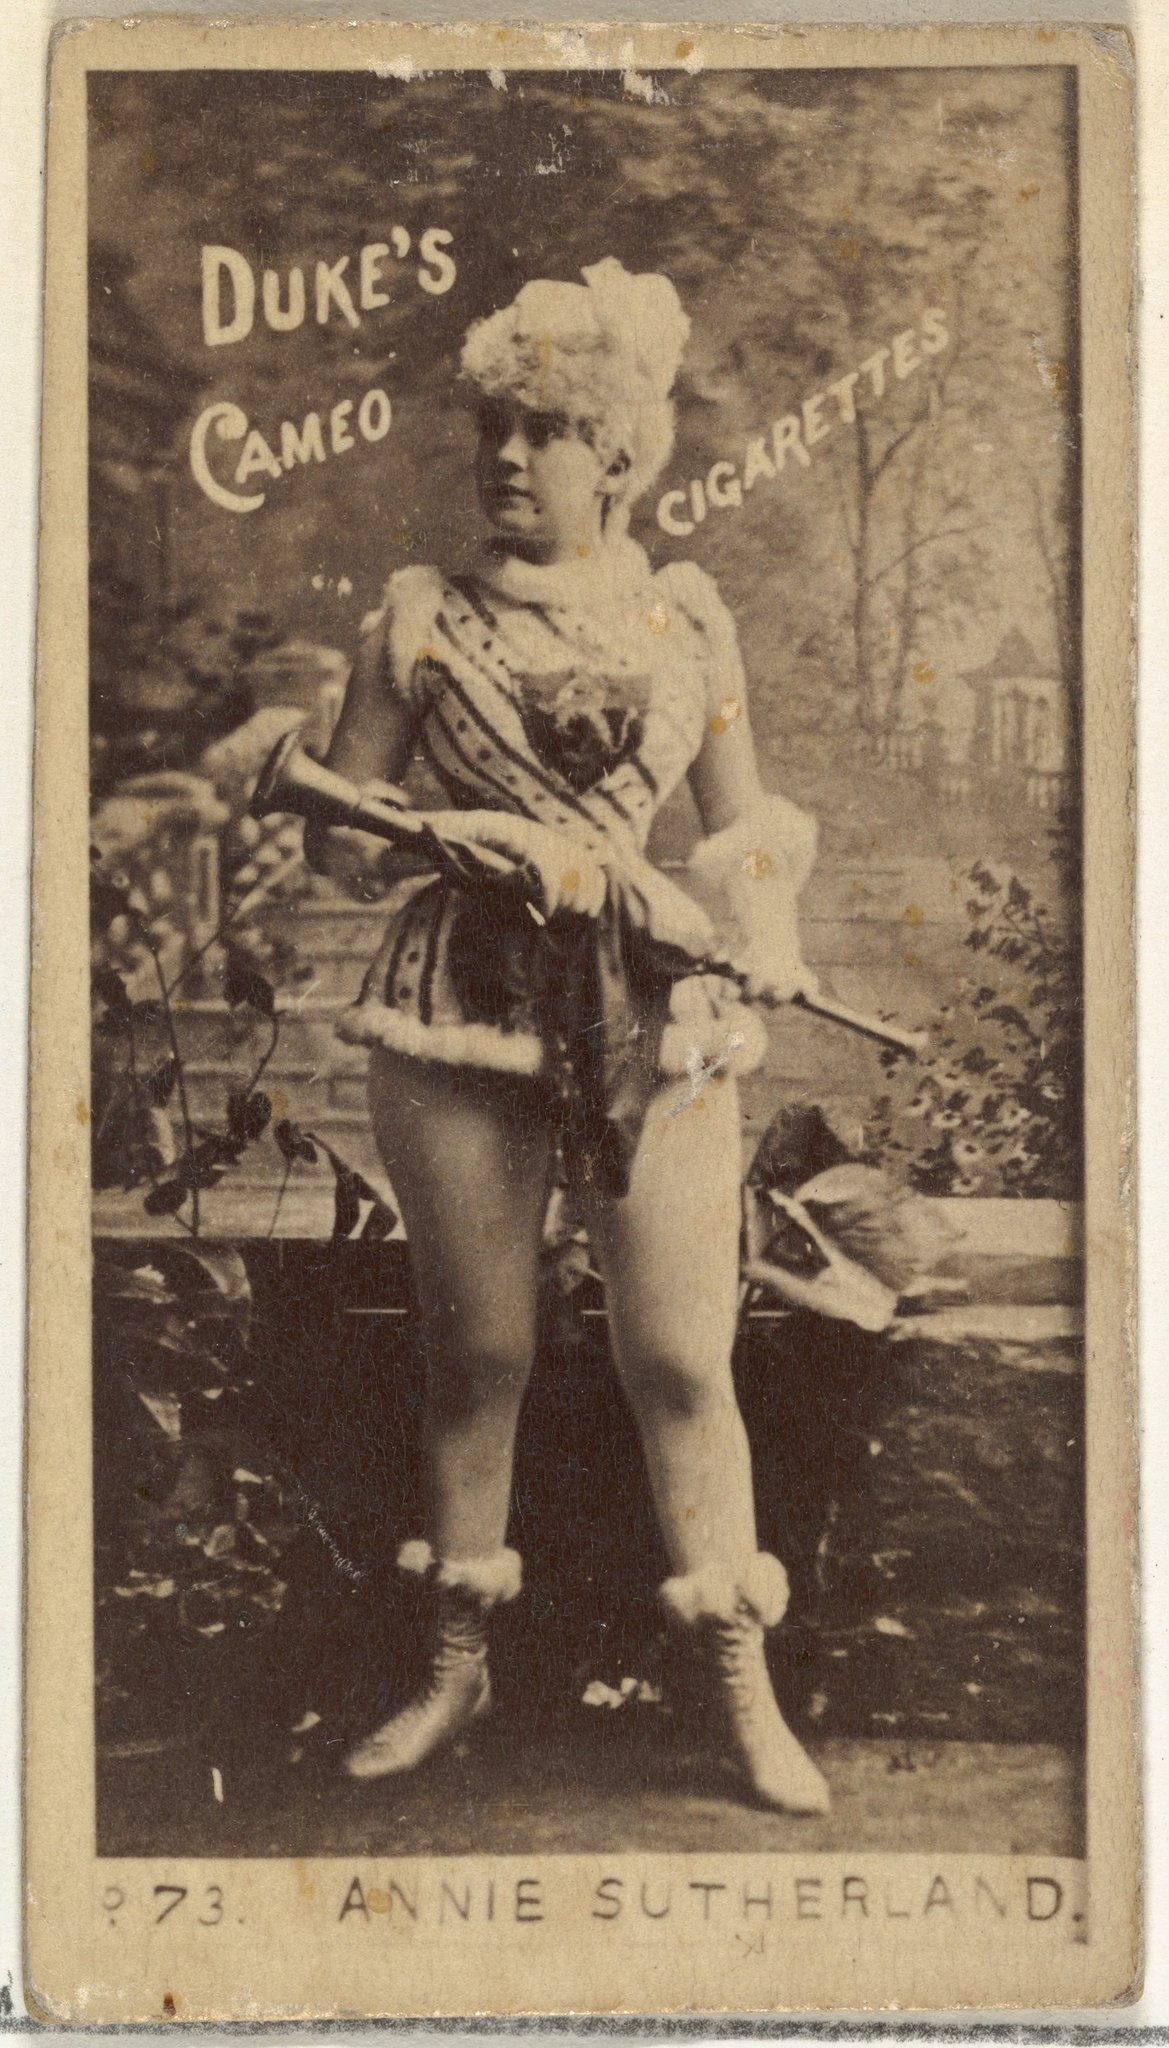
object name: photograph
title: Card Number 73, Annie Sutherland, from the Actors and Actresses series (N145-4) issued by Duke Sons & Co. to promote Cameo Cigarettes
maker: w. duke, sons & co.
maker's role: publisher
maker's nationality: american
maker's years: 1870-1920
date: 1880-1889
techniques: albumen silver print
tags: portraits,women,actresses